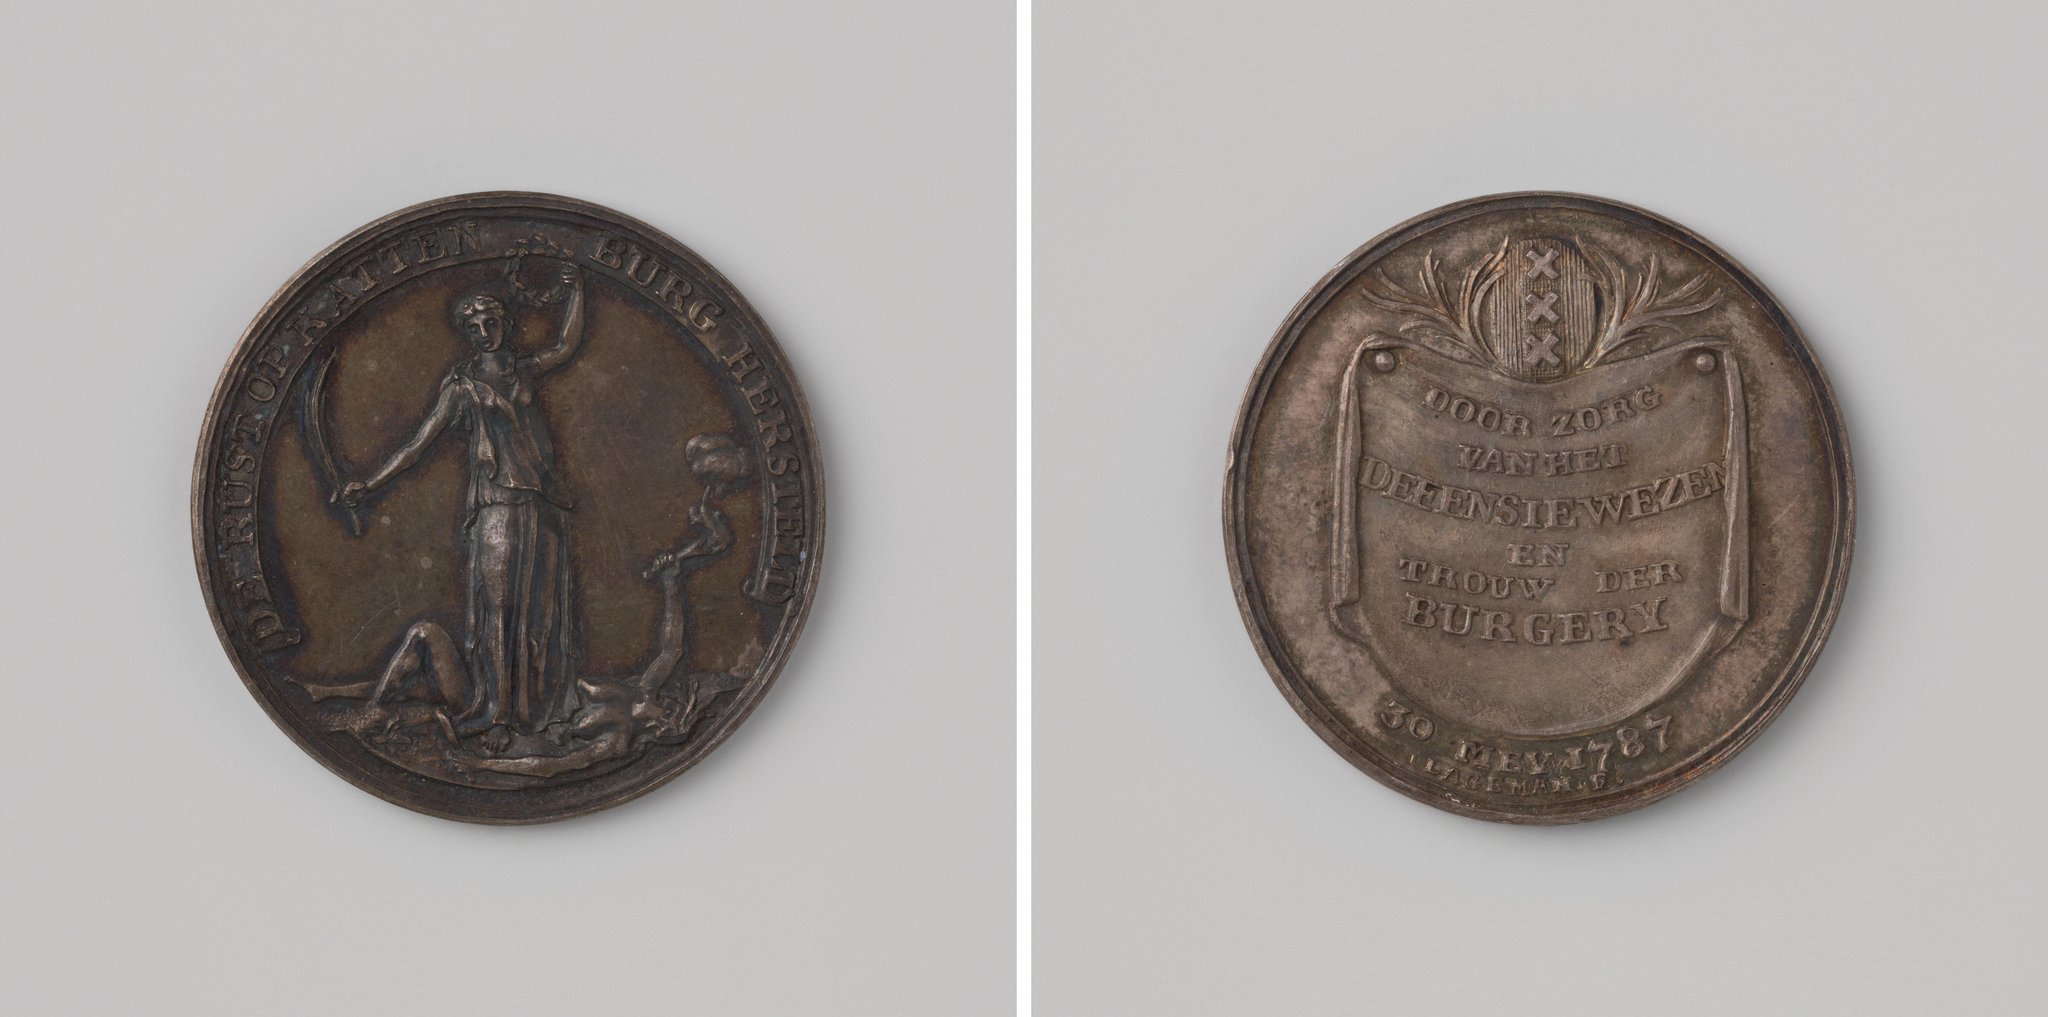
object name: history medal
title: Inname van Kattenburg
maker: johannes michiel lageman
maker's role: silversmith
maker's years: 1735-1809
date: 1787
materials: silver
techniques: striking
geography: amsterdam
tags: kattenburg, kattenburgoproer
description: Zilveren penning. Voorzijde: vrouw met palmtak en lauwerkrans, voorstellende Overwinning, vertrapt Oproer, die ter aarde ligt met fakkel en gebroken zwaard in handen binnen omschrift op wimpel. Keerzijde: wapenschild tussen palmtakken boven doek met opschrift